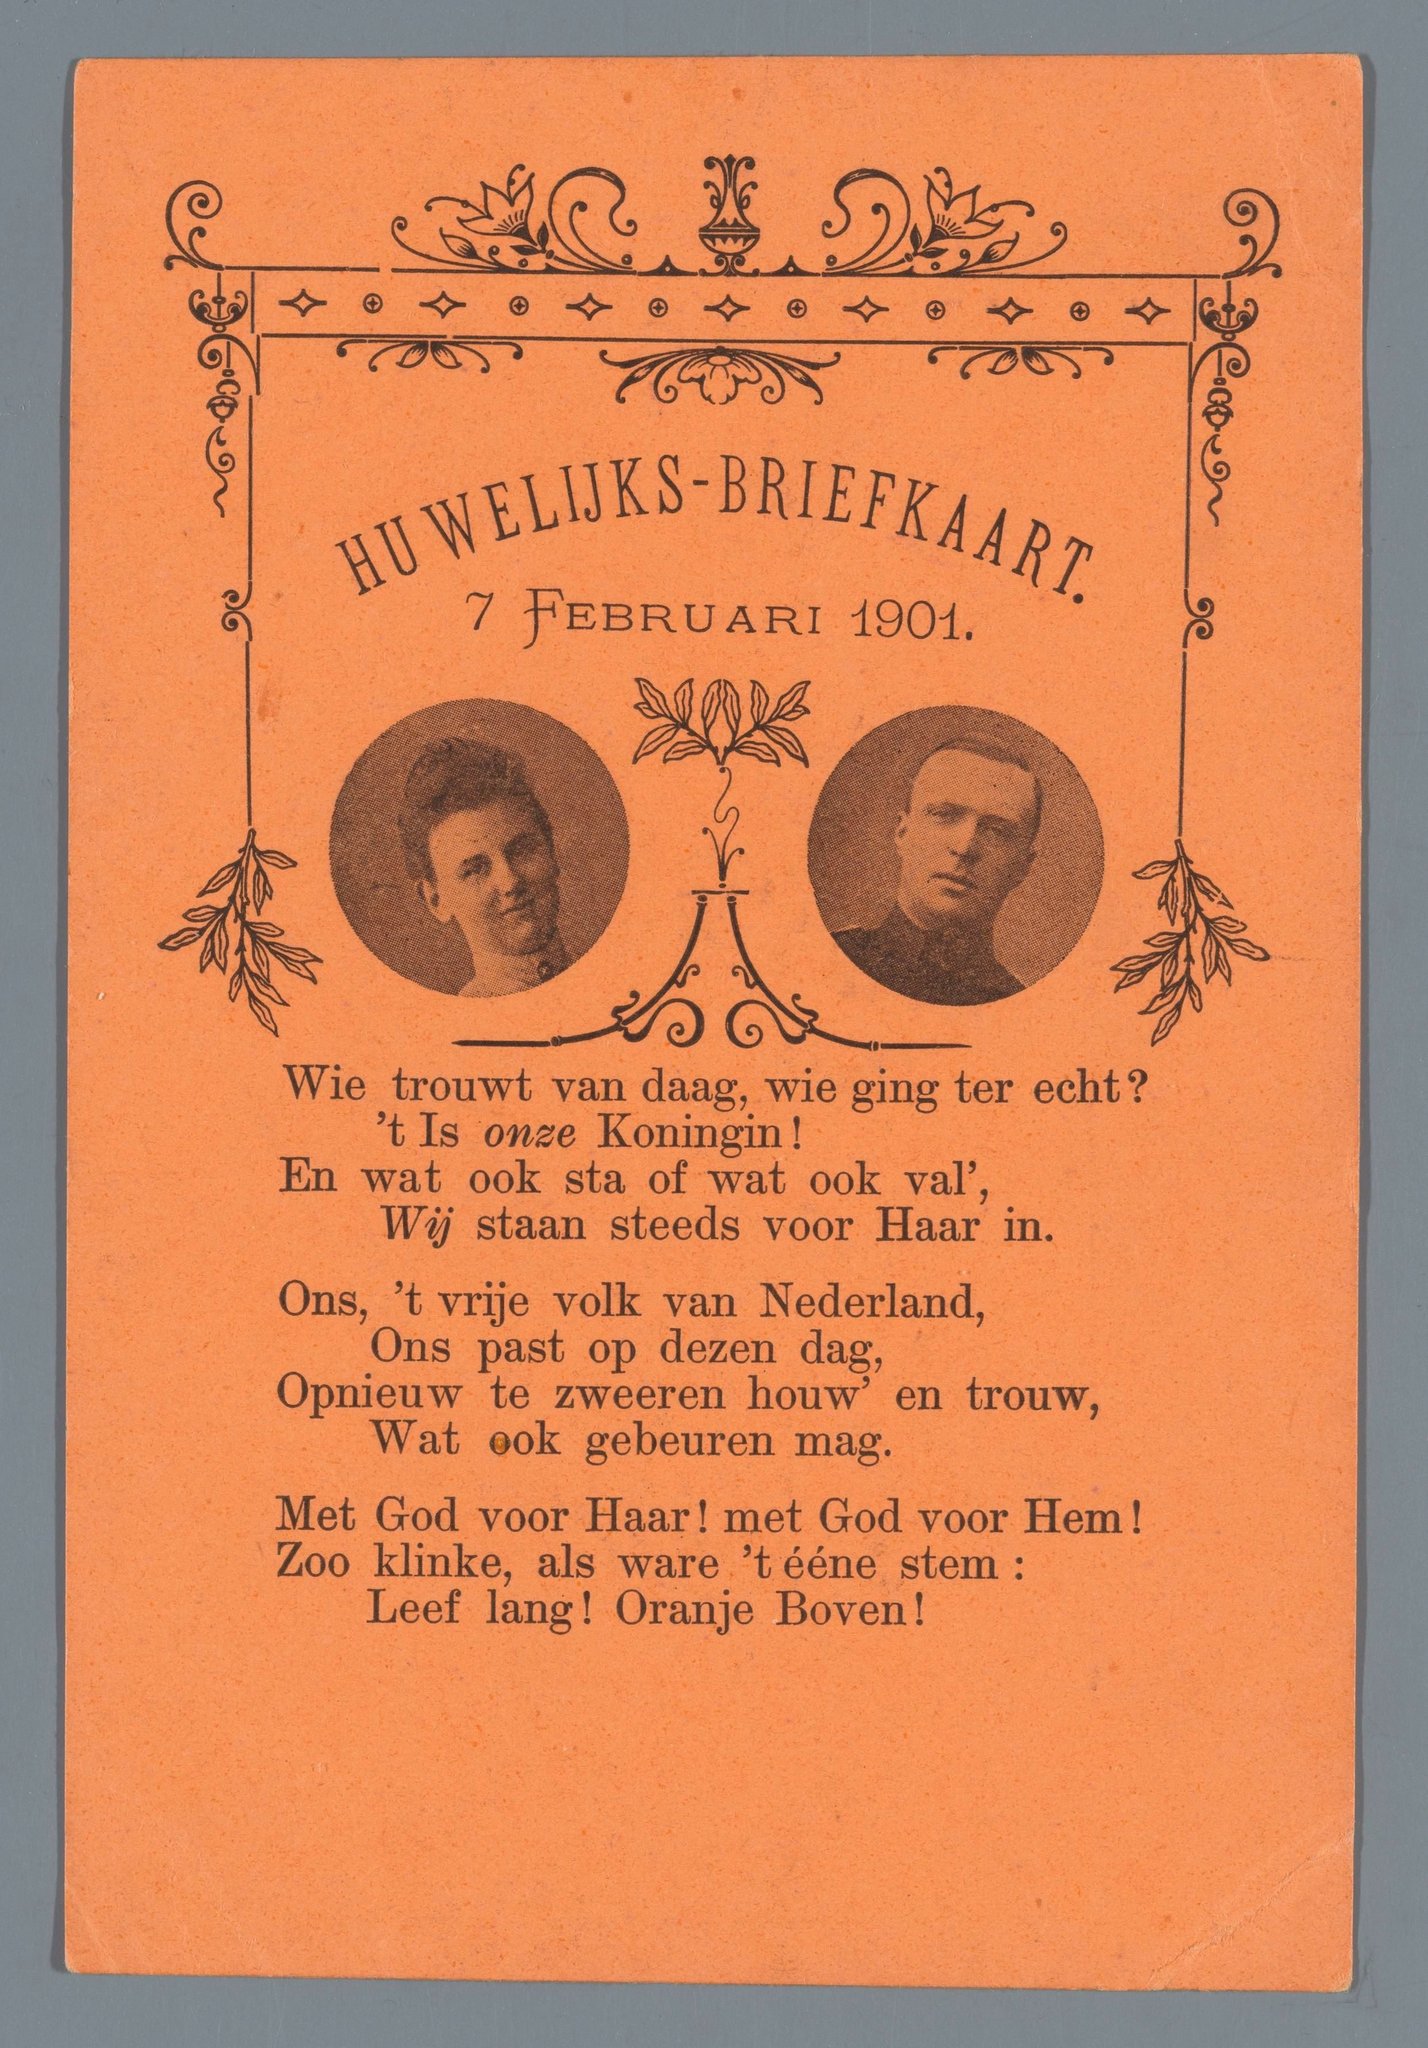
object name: ansichtkaart, prentbriefkaart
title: Huwelijks-briefkaart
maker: Anonymous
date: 1901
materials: cardboard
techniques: autotype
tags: print maker, wilhelmina of the netherlands, hendrik (prins der nederlanden (1876-1934)), prince, queen